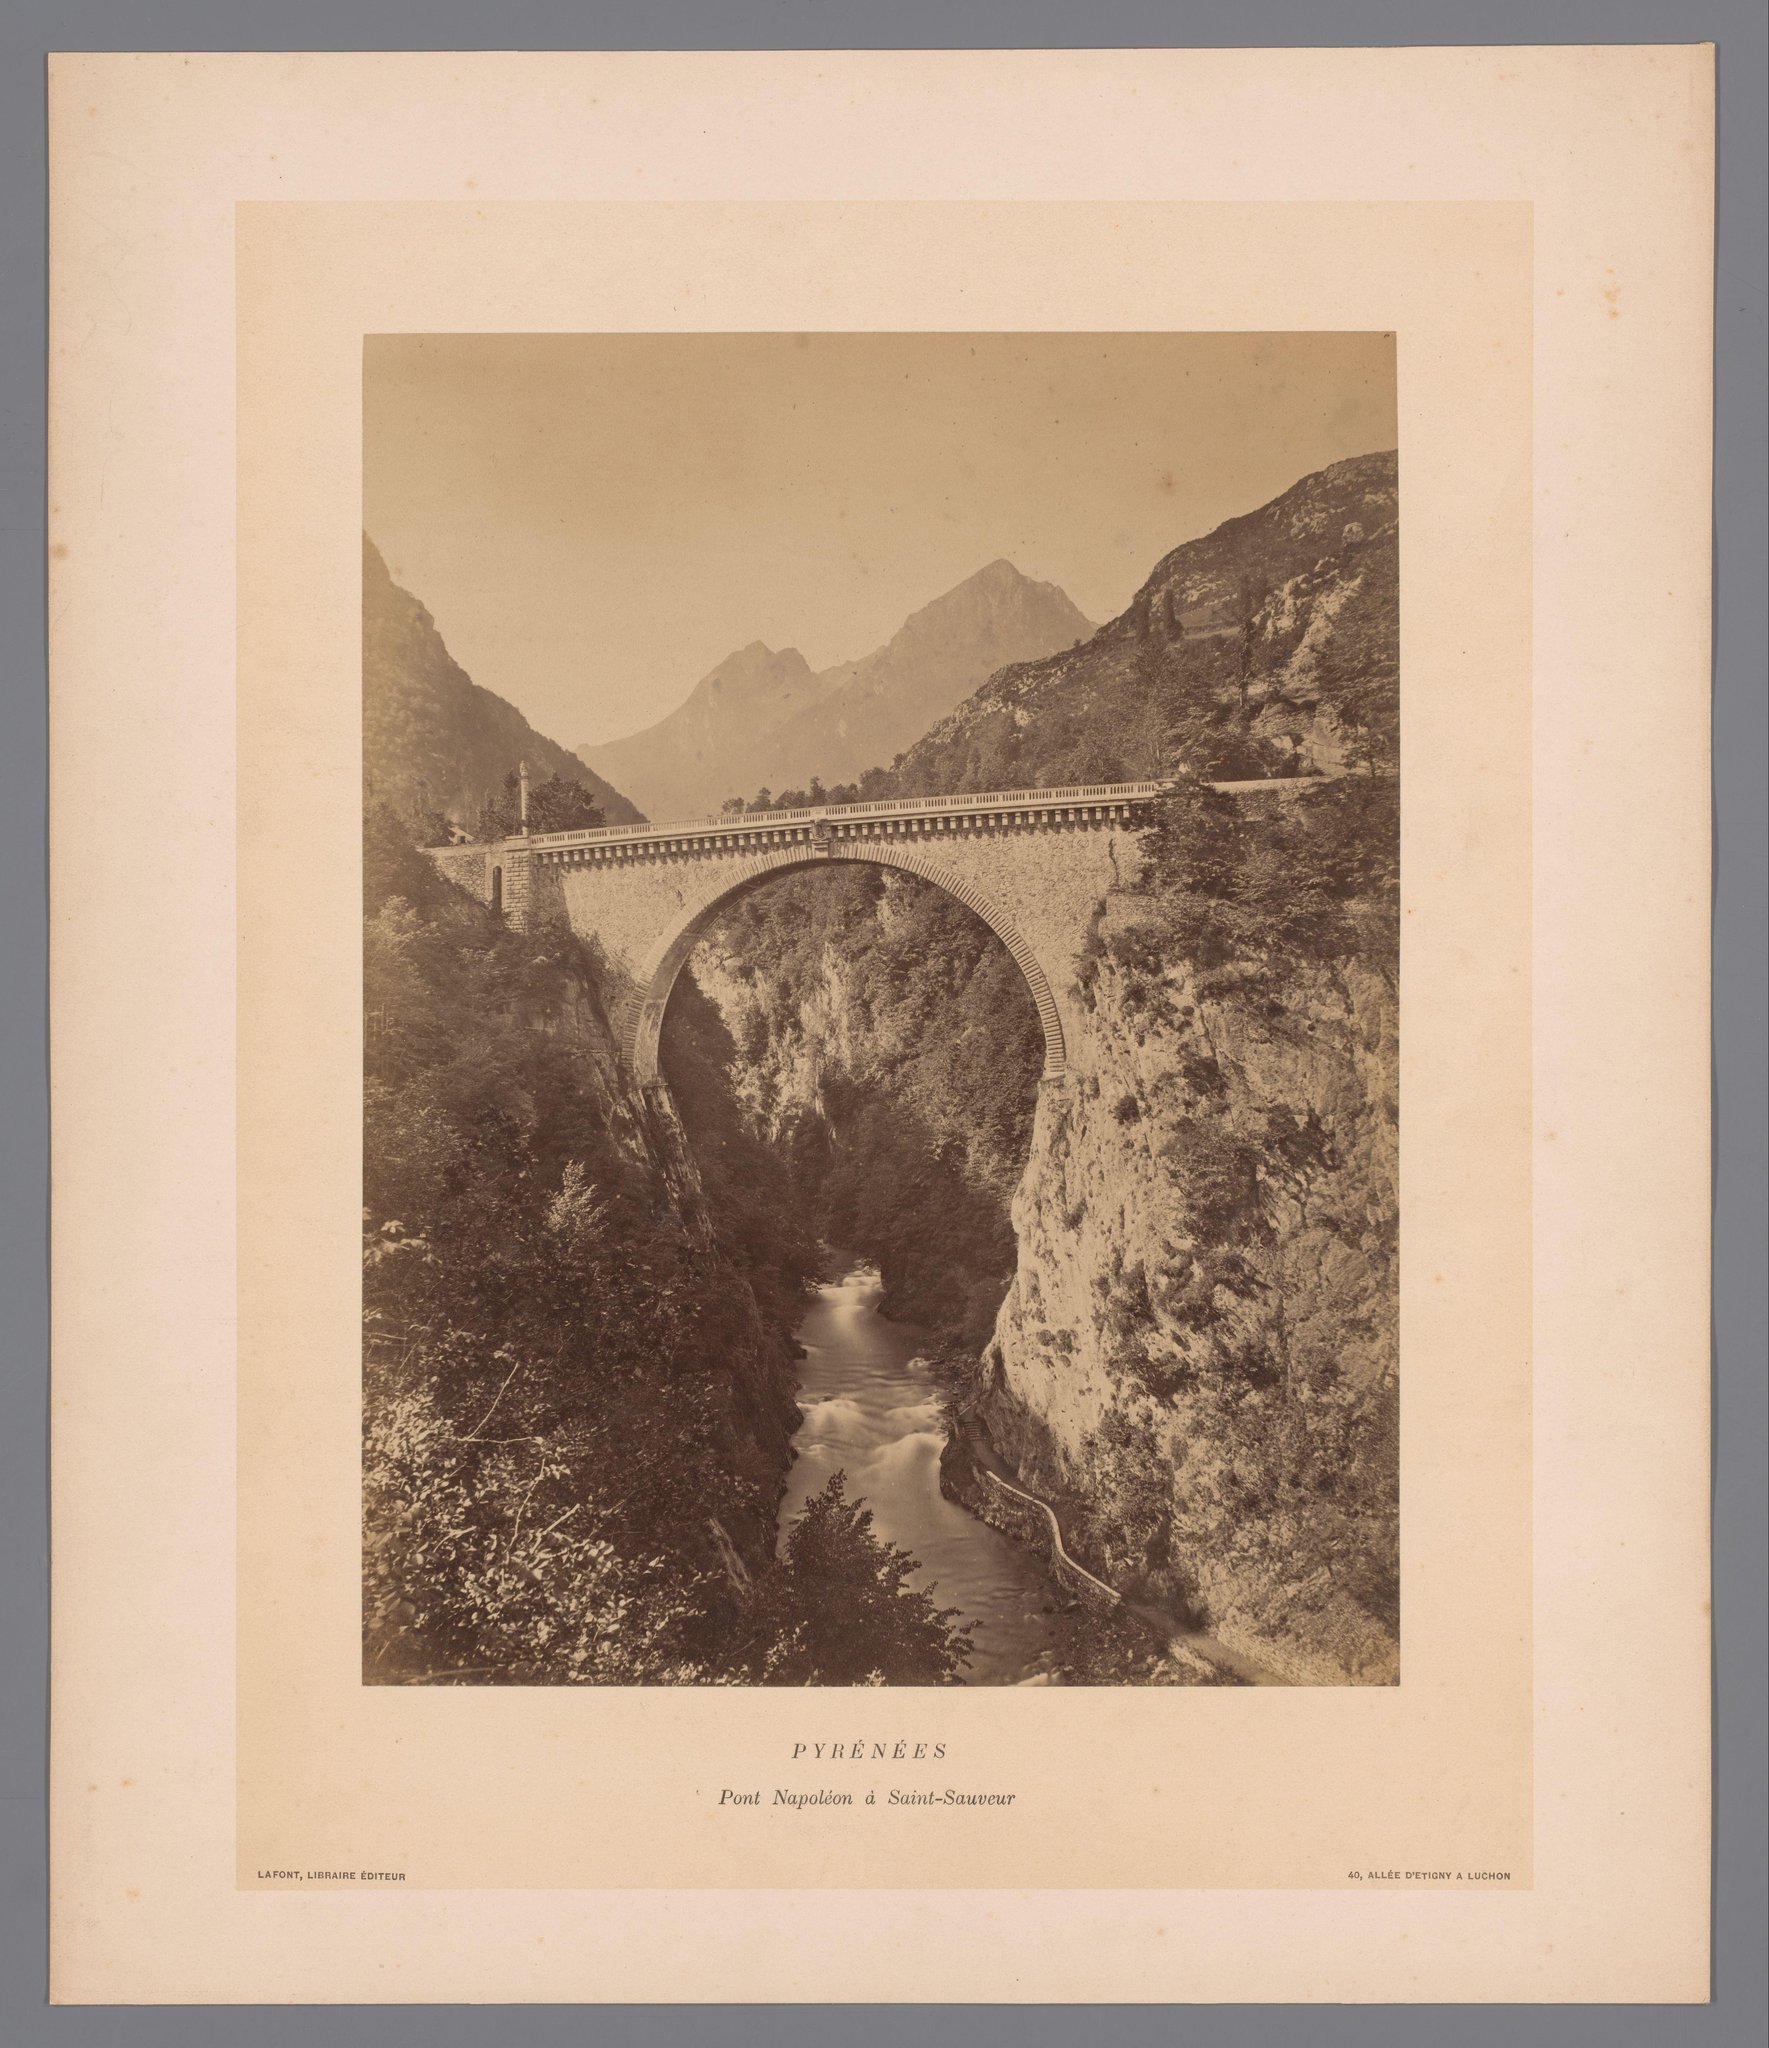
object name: photograph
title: "PYRÉNÉES, Pont Napoléon à Saint-Sauveur", Luz-Saint-Sauveur, Frankrijk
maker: Anonymous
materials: cardboard, paper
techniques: albumen print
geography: luchon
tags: pyreneeën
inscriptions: date: ‘11/12 October 1884.’, caption: ‘PYRÉNÉES//Pont Napoléon à Saint-Sauveur’, caption: ‘LAFONT LIBRAIRE ÉDITEUR//40 ALLÉE D'ETIGNY A LUCHON’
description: Frontaal aanzicht op een de Pont Napoleon, een boogbrug gebouwd in 1860.